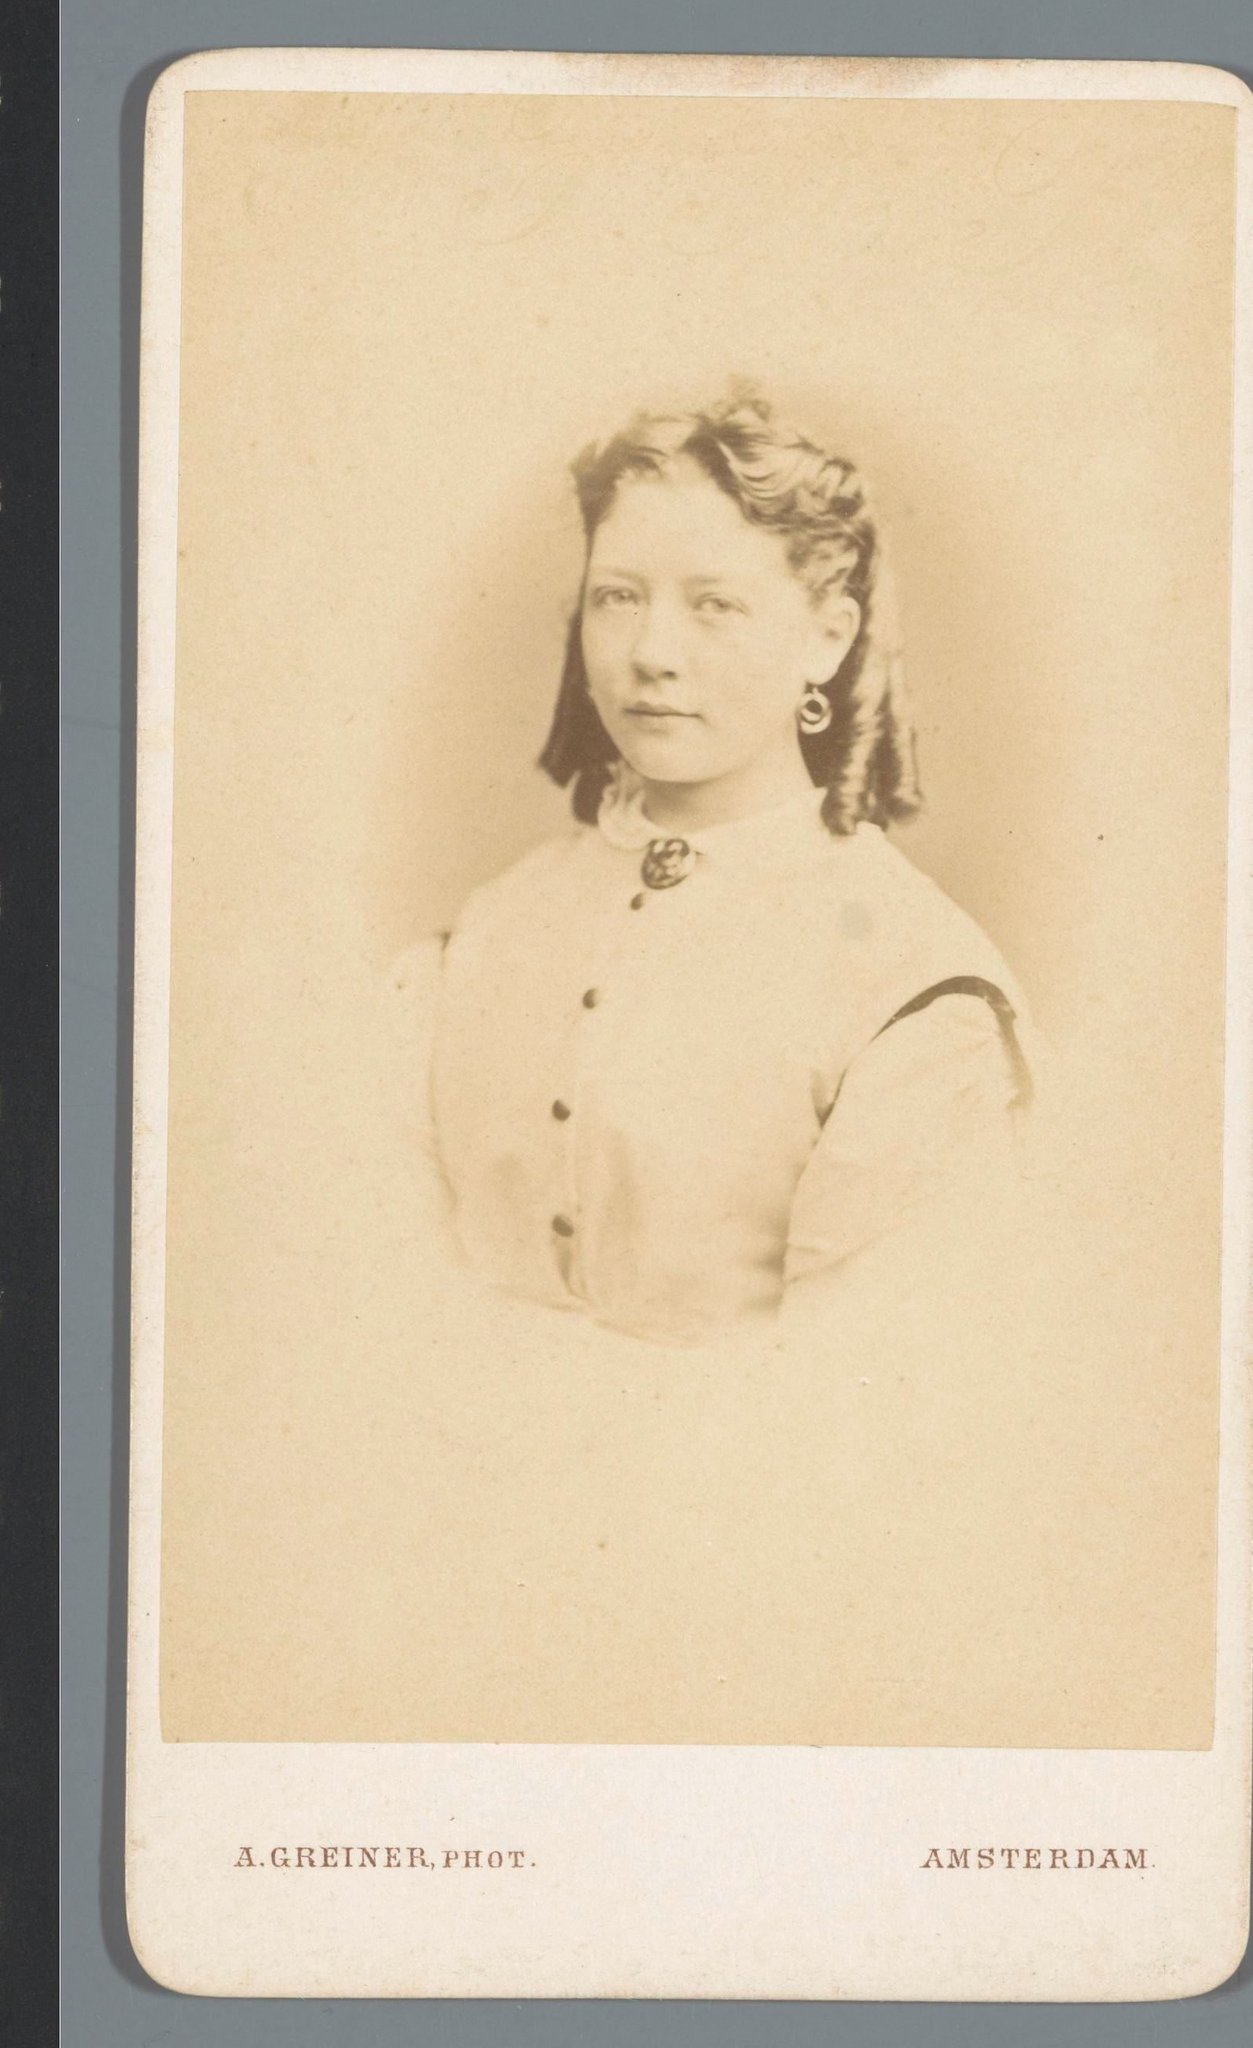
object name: photograph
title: Portret van een onbekende vrouw met pijpenkrullen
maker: albert greiner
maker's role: fotograaf, fotostudio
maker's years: 1833-1890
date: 1861-1874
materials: cardboard, paper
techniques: albumen print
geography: amsterdam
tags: historical persons - bb - woman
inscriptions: inscription: ‘AG/ A. GREINER/ Photograf/ NIEUWENDIJK L. 87/ AMSTERDAM’